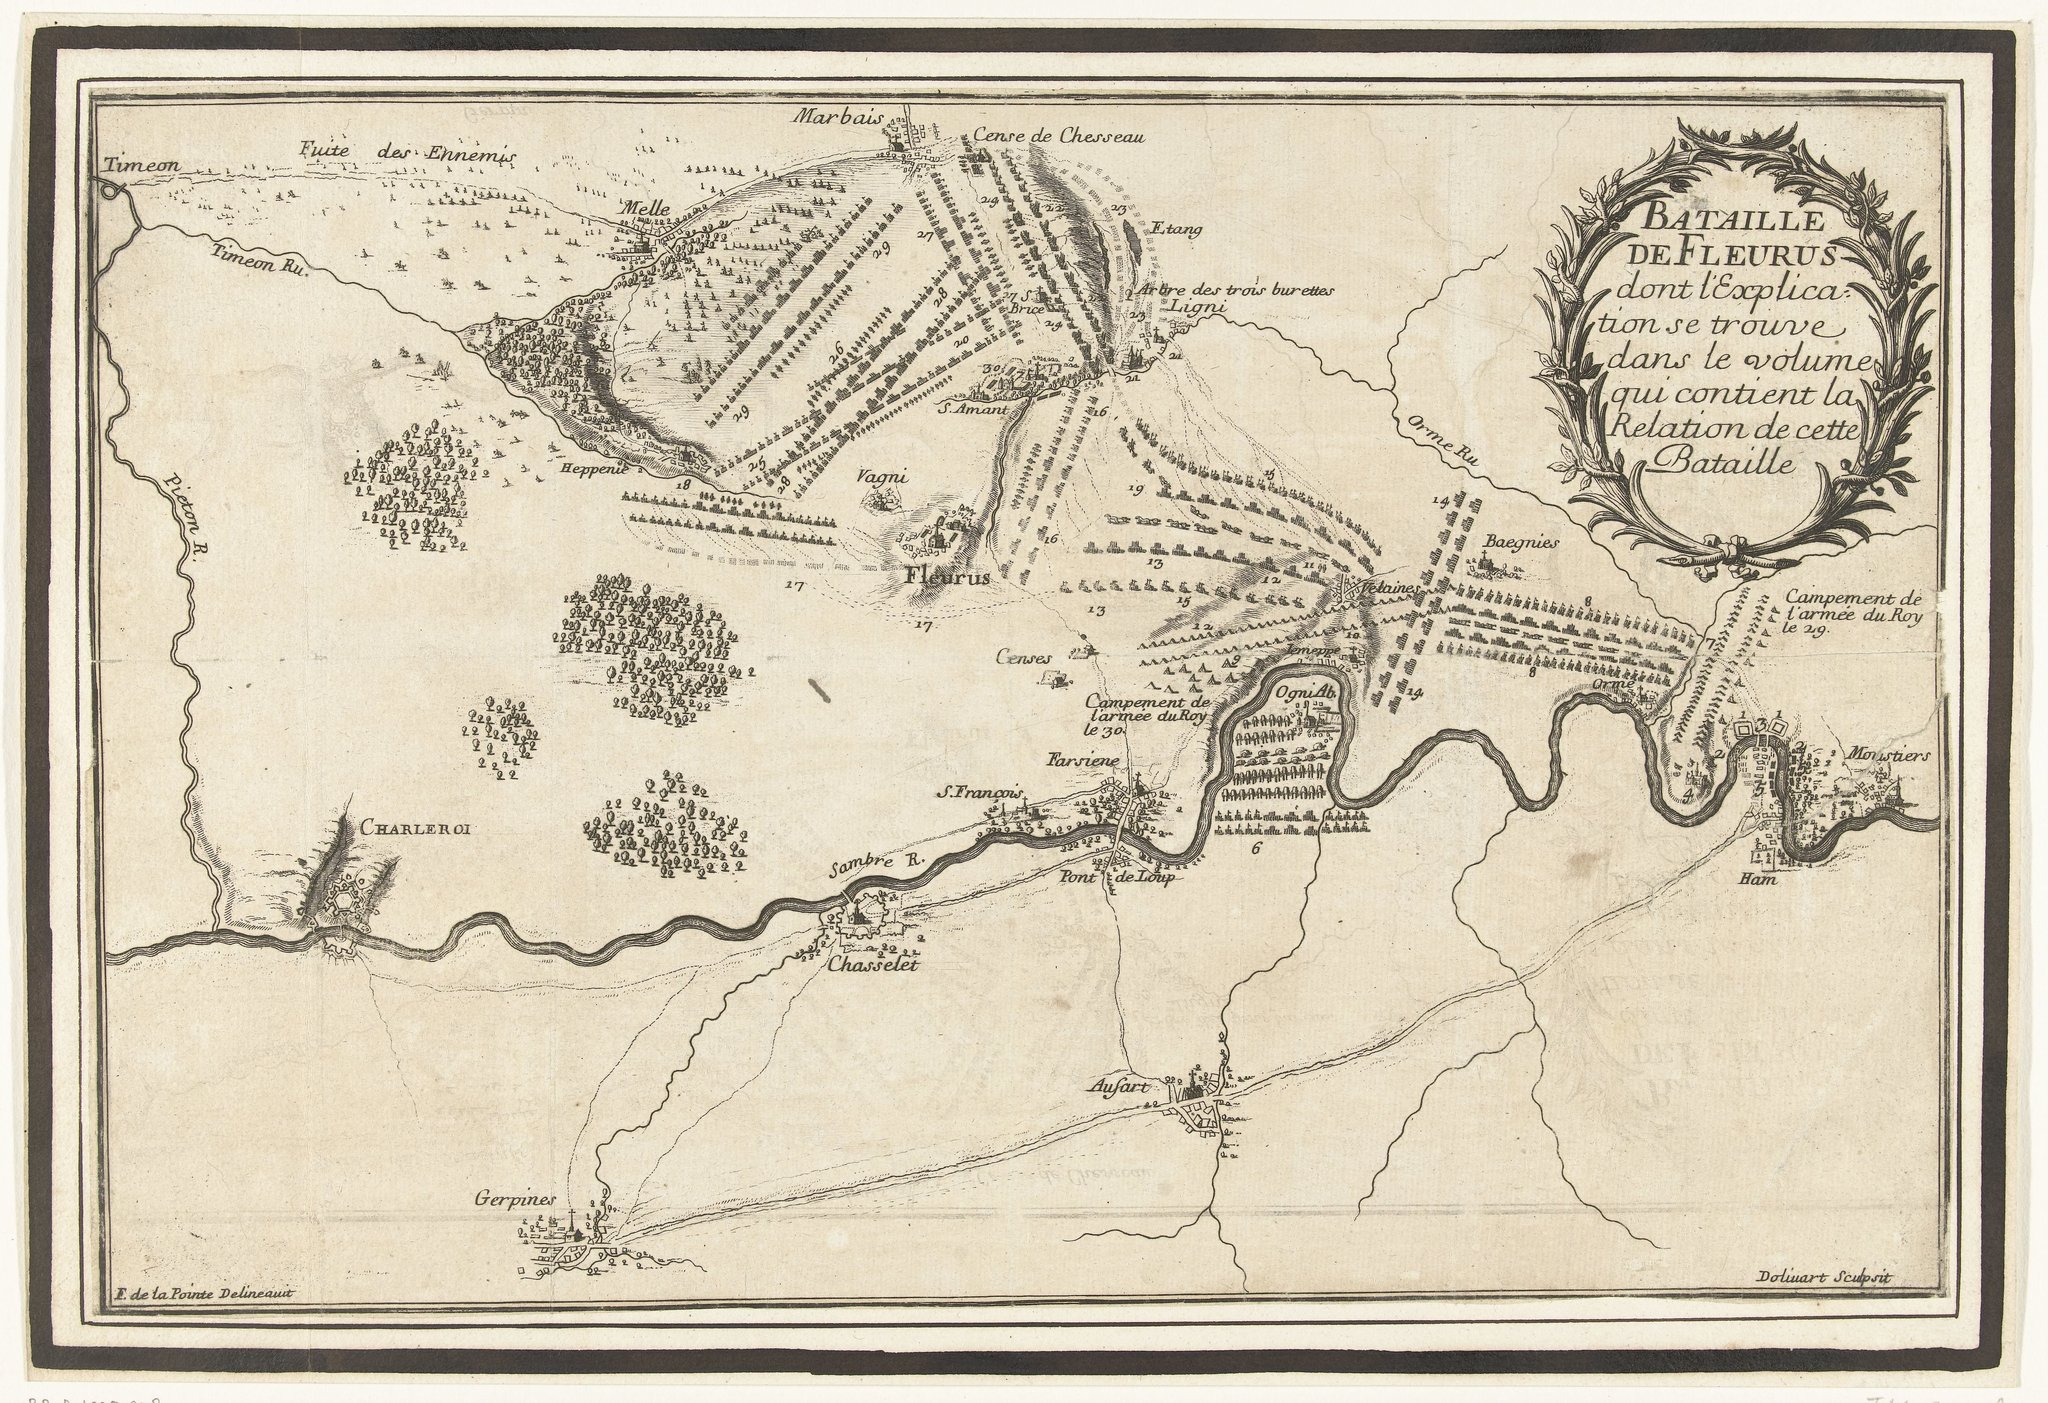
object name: map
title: Slag bij Fleurus, 1690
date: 1690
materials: paper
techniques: etching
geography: france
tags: maps of separate countries or regions, battle (+ land forces)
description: Kaart van de omgeving van Fleurus bij Charleroi met de posities van de legers bij de slag bij Fleurus, een overwinning van de Fransen onder de hertog van Luxembourg op het geallieerde leger onder de prins van Waldeck, 1 juli 1690.